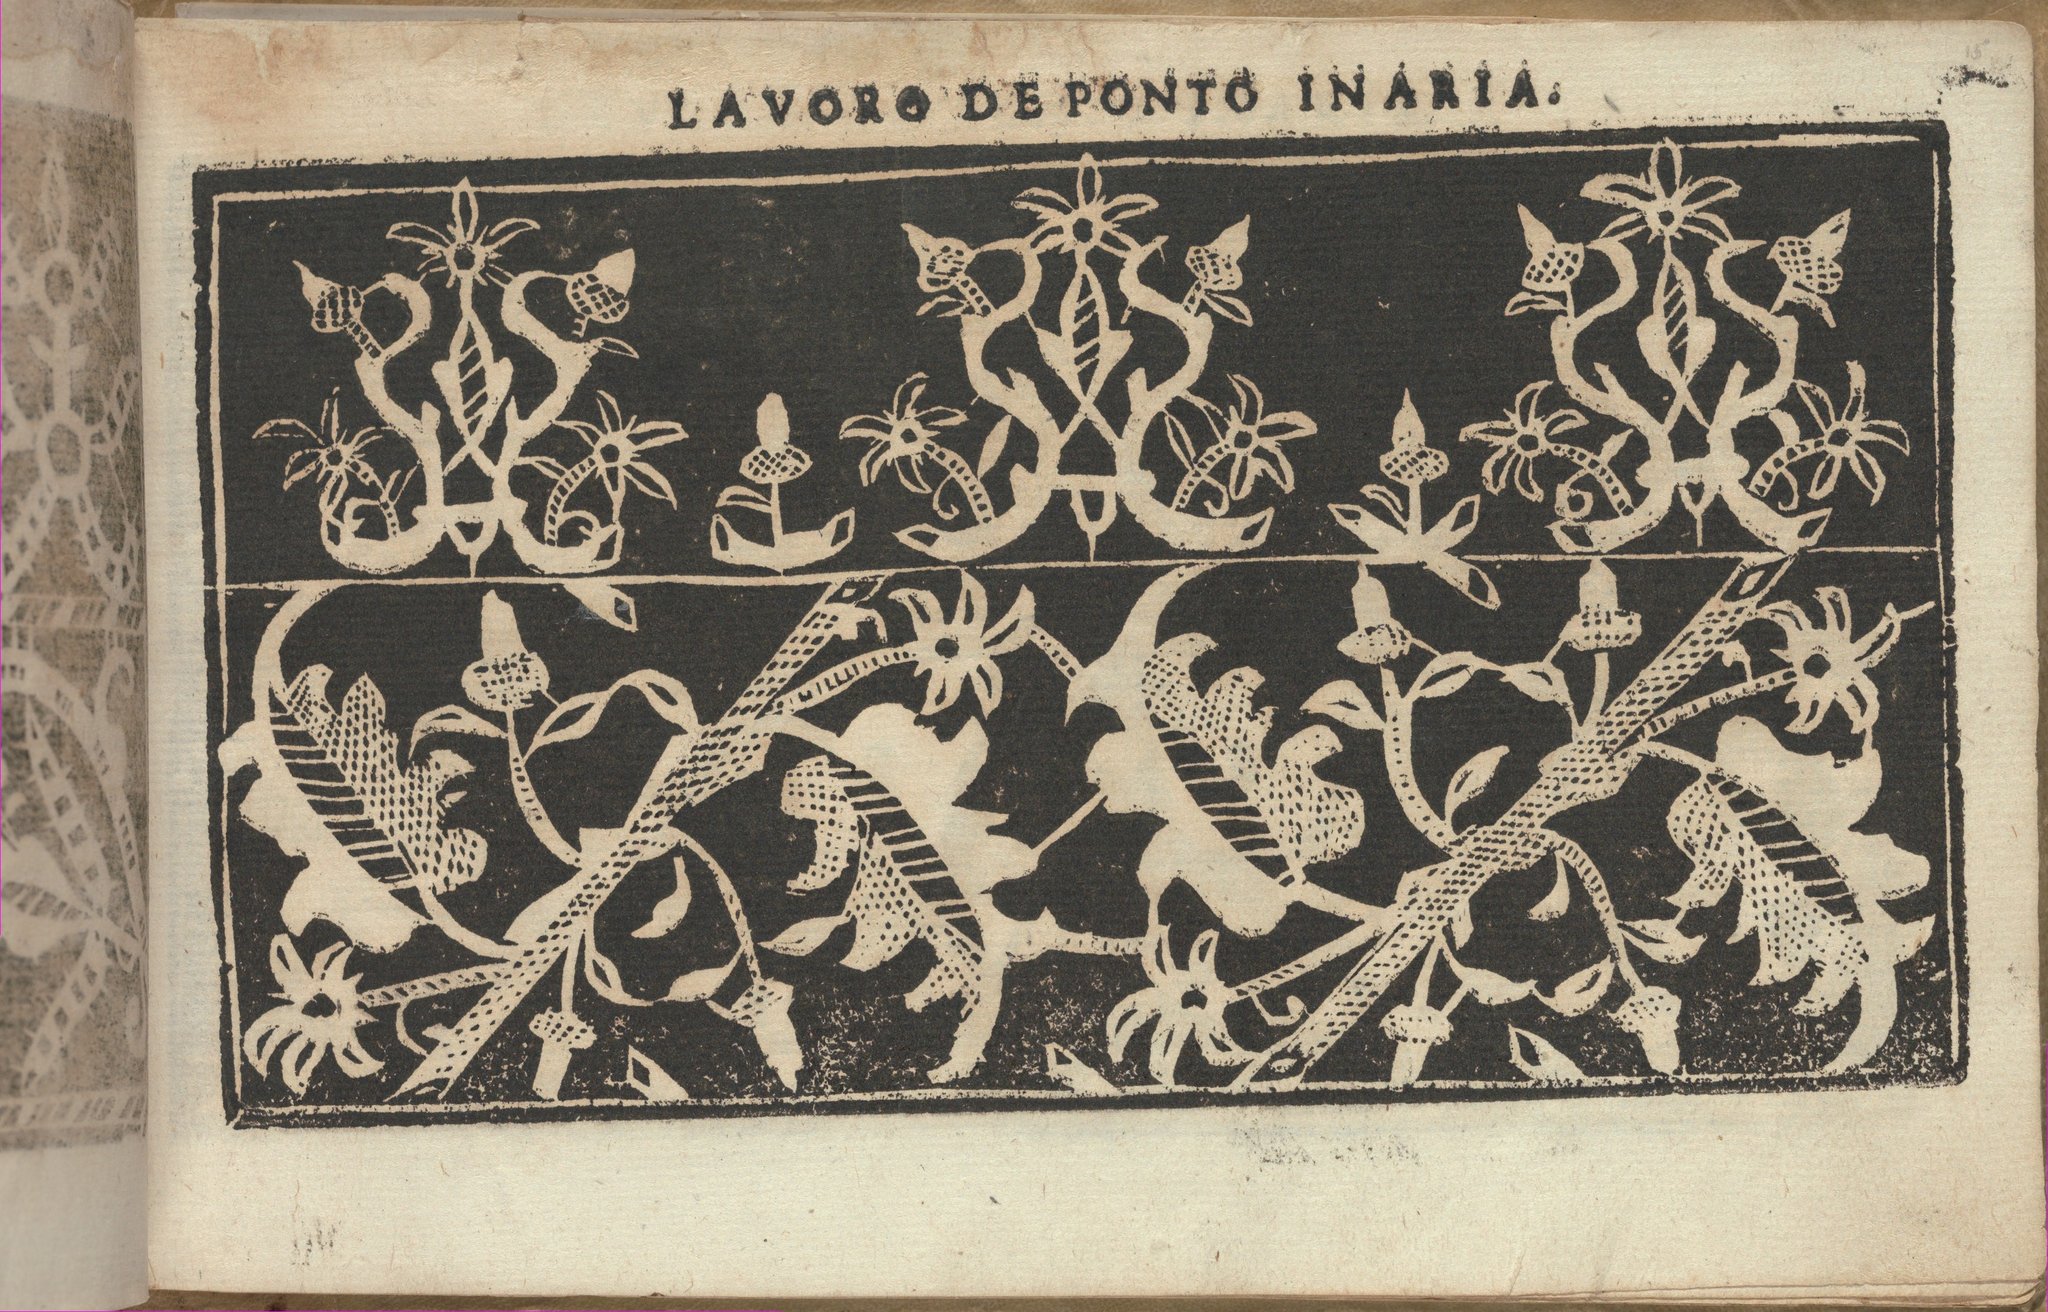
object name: book print ornament architecture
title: Studio delle virtuose Dame, page 15 (recto)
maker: isabella catanea parasole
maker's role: designer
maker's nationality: italian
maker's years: 1565-1625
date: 1597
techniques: woodcut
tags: flowers,acorns,leaves